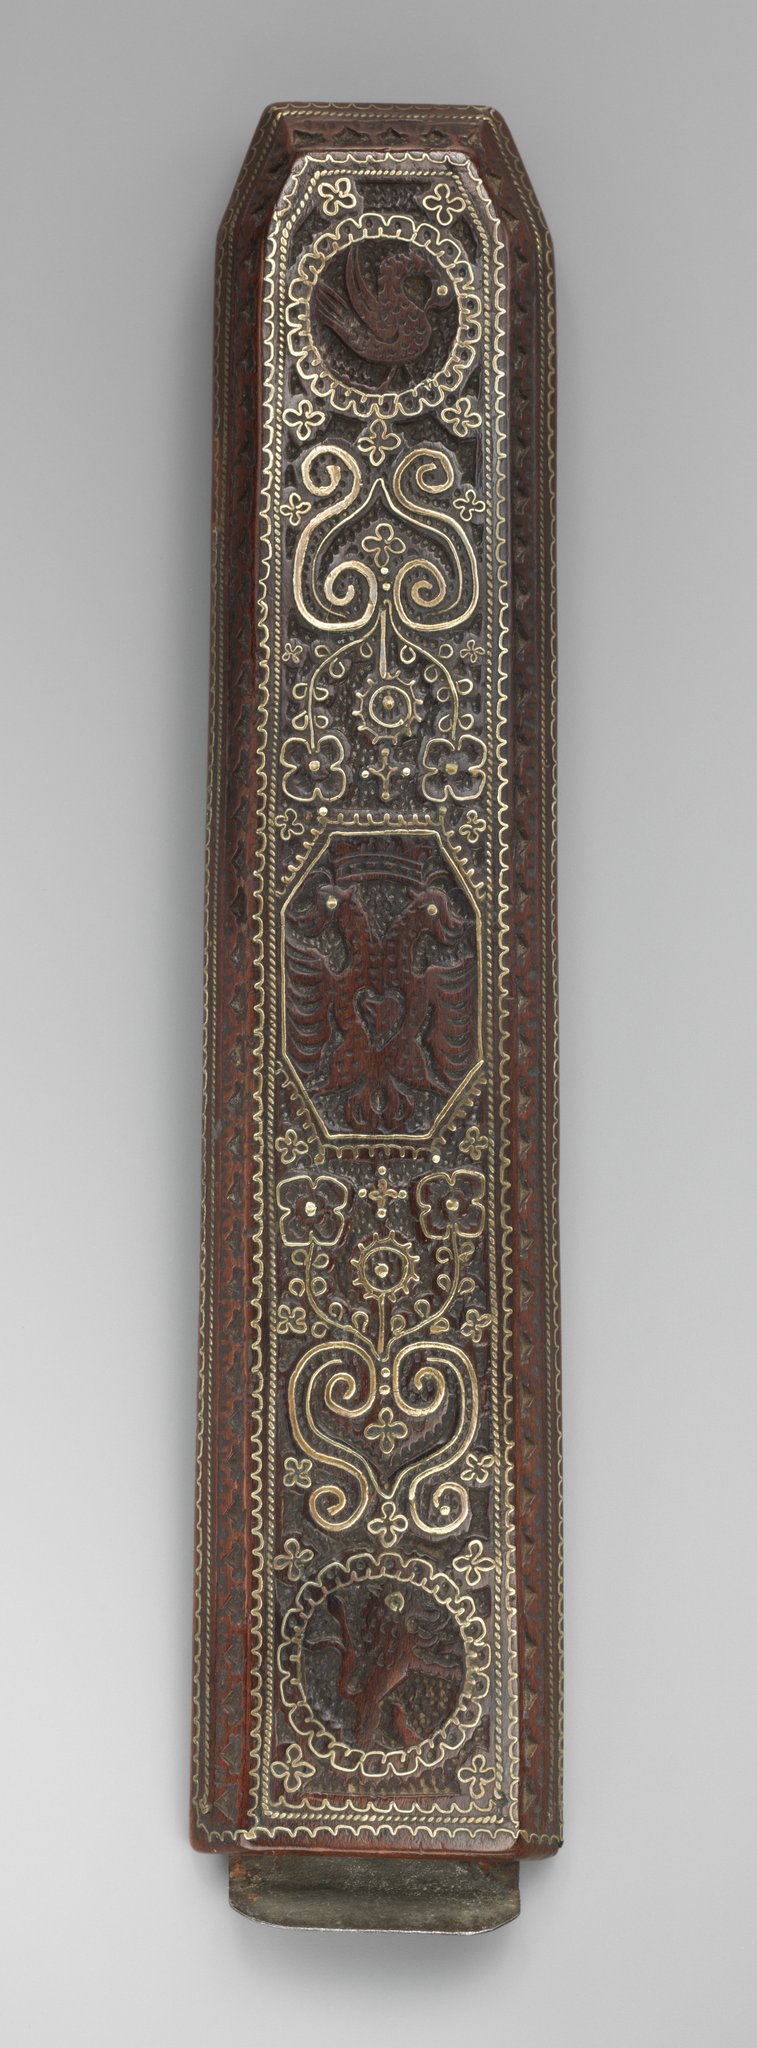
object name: snuff rasp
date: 1801-1900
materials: brass, iron, wood